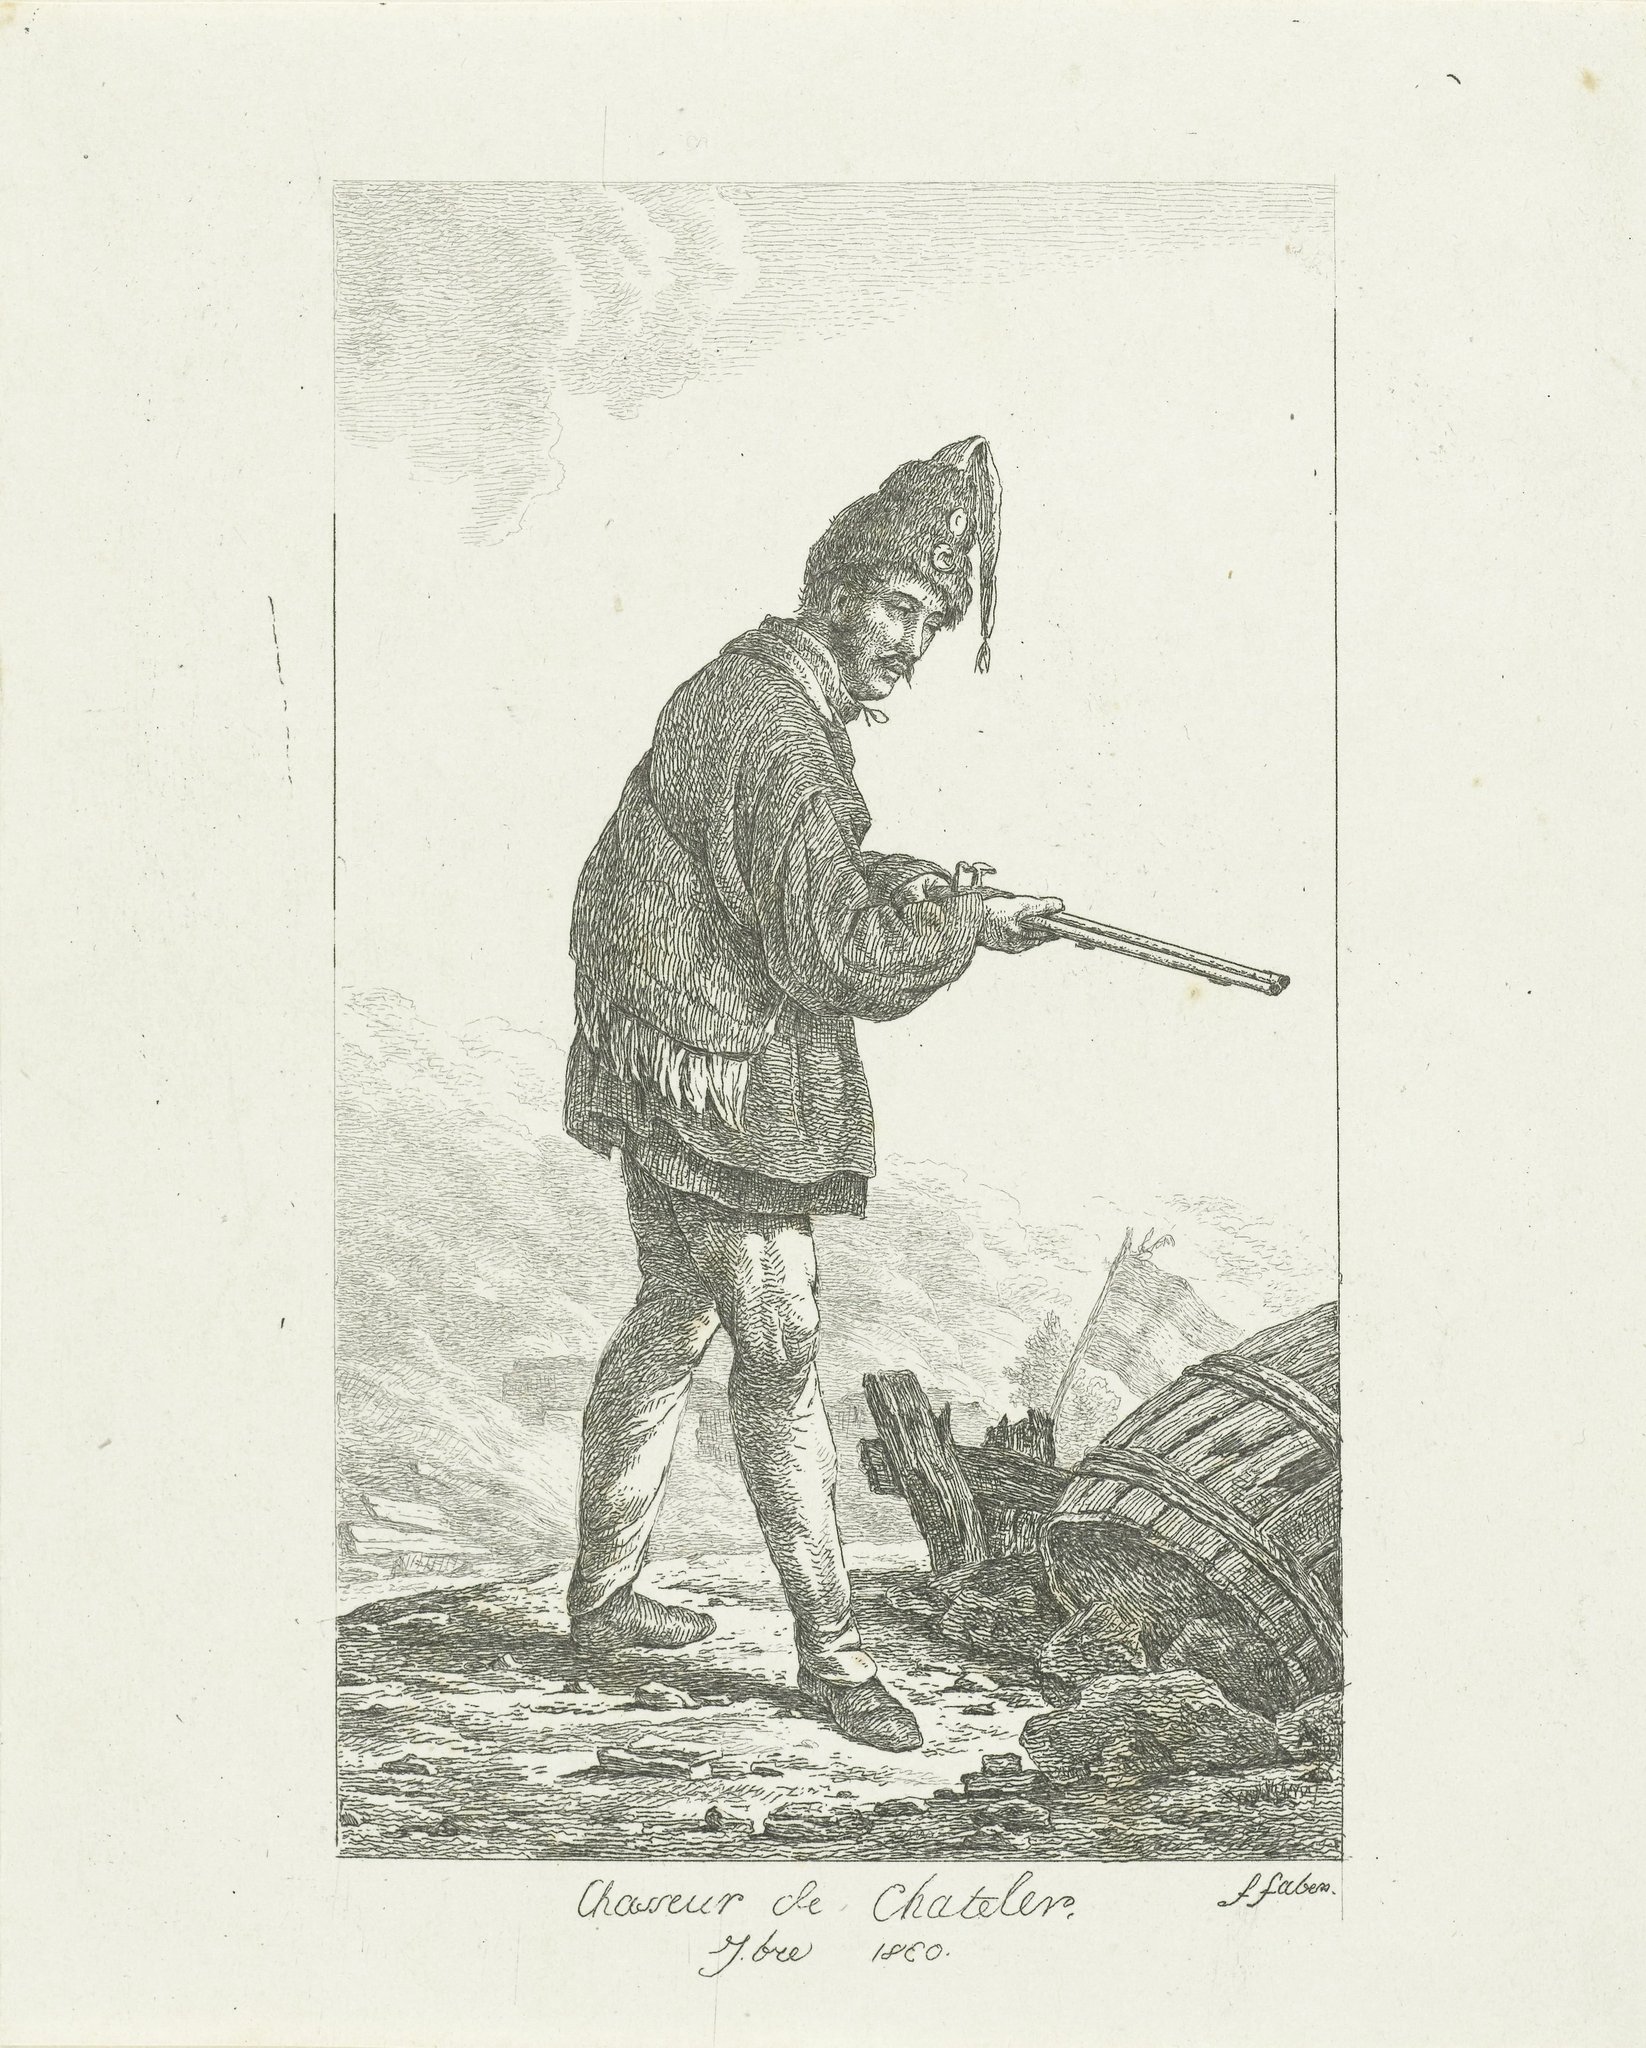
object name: print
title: Chasseur de Chasteler 7bre 1830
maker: frédéric théodore faber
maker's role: print maker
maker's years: 1782-1844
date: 1842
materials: paper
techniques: etching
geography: brussels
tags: private soldier (+ during the battle)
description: Een soldaat, ten voeten uit, met een geweer in beide handen. Op de achtergrond een vlag.